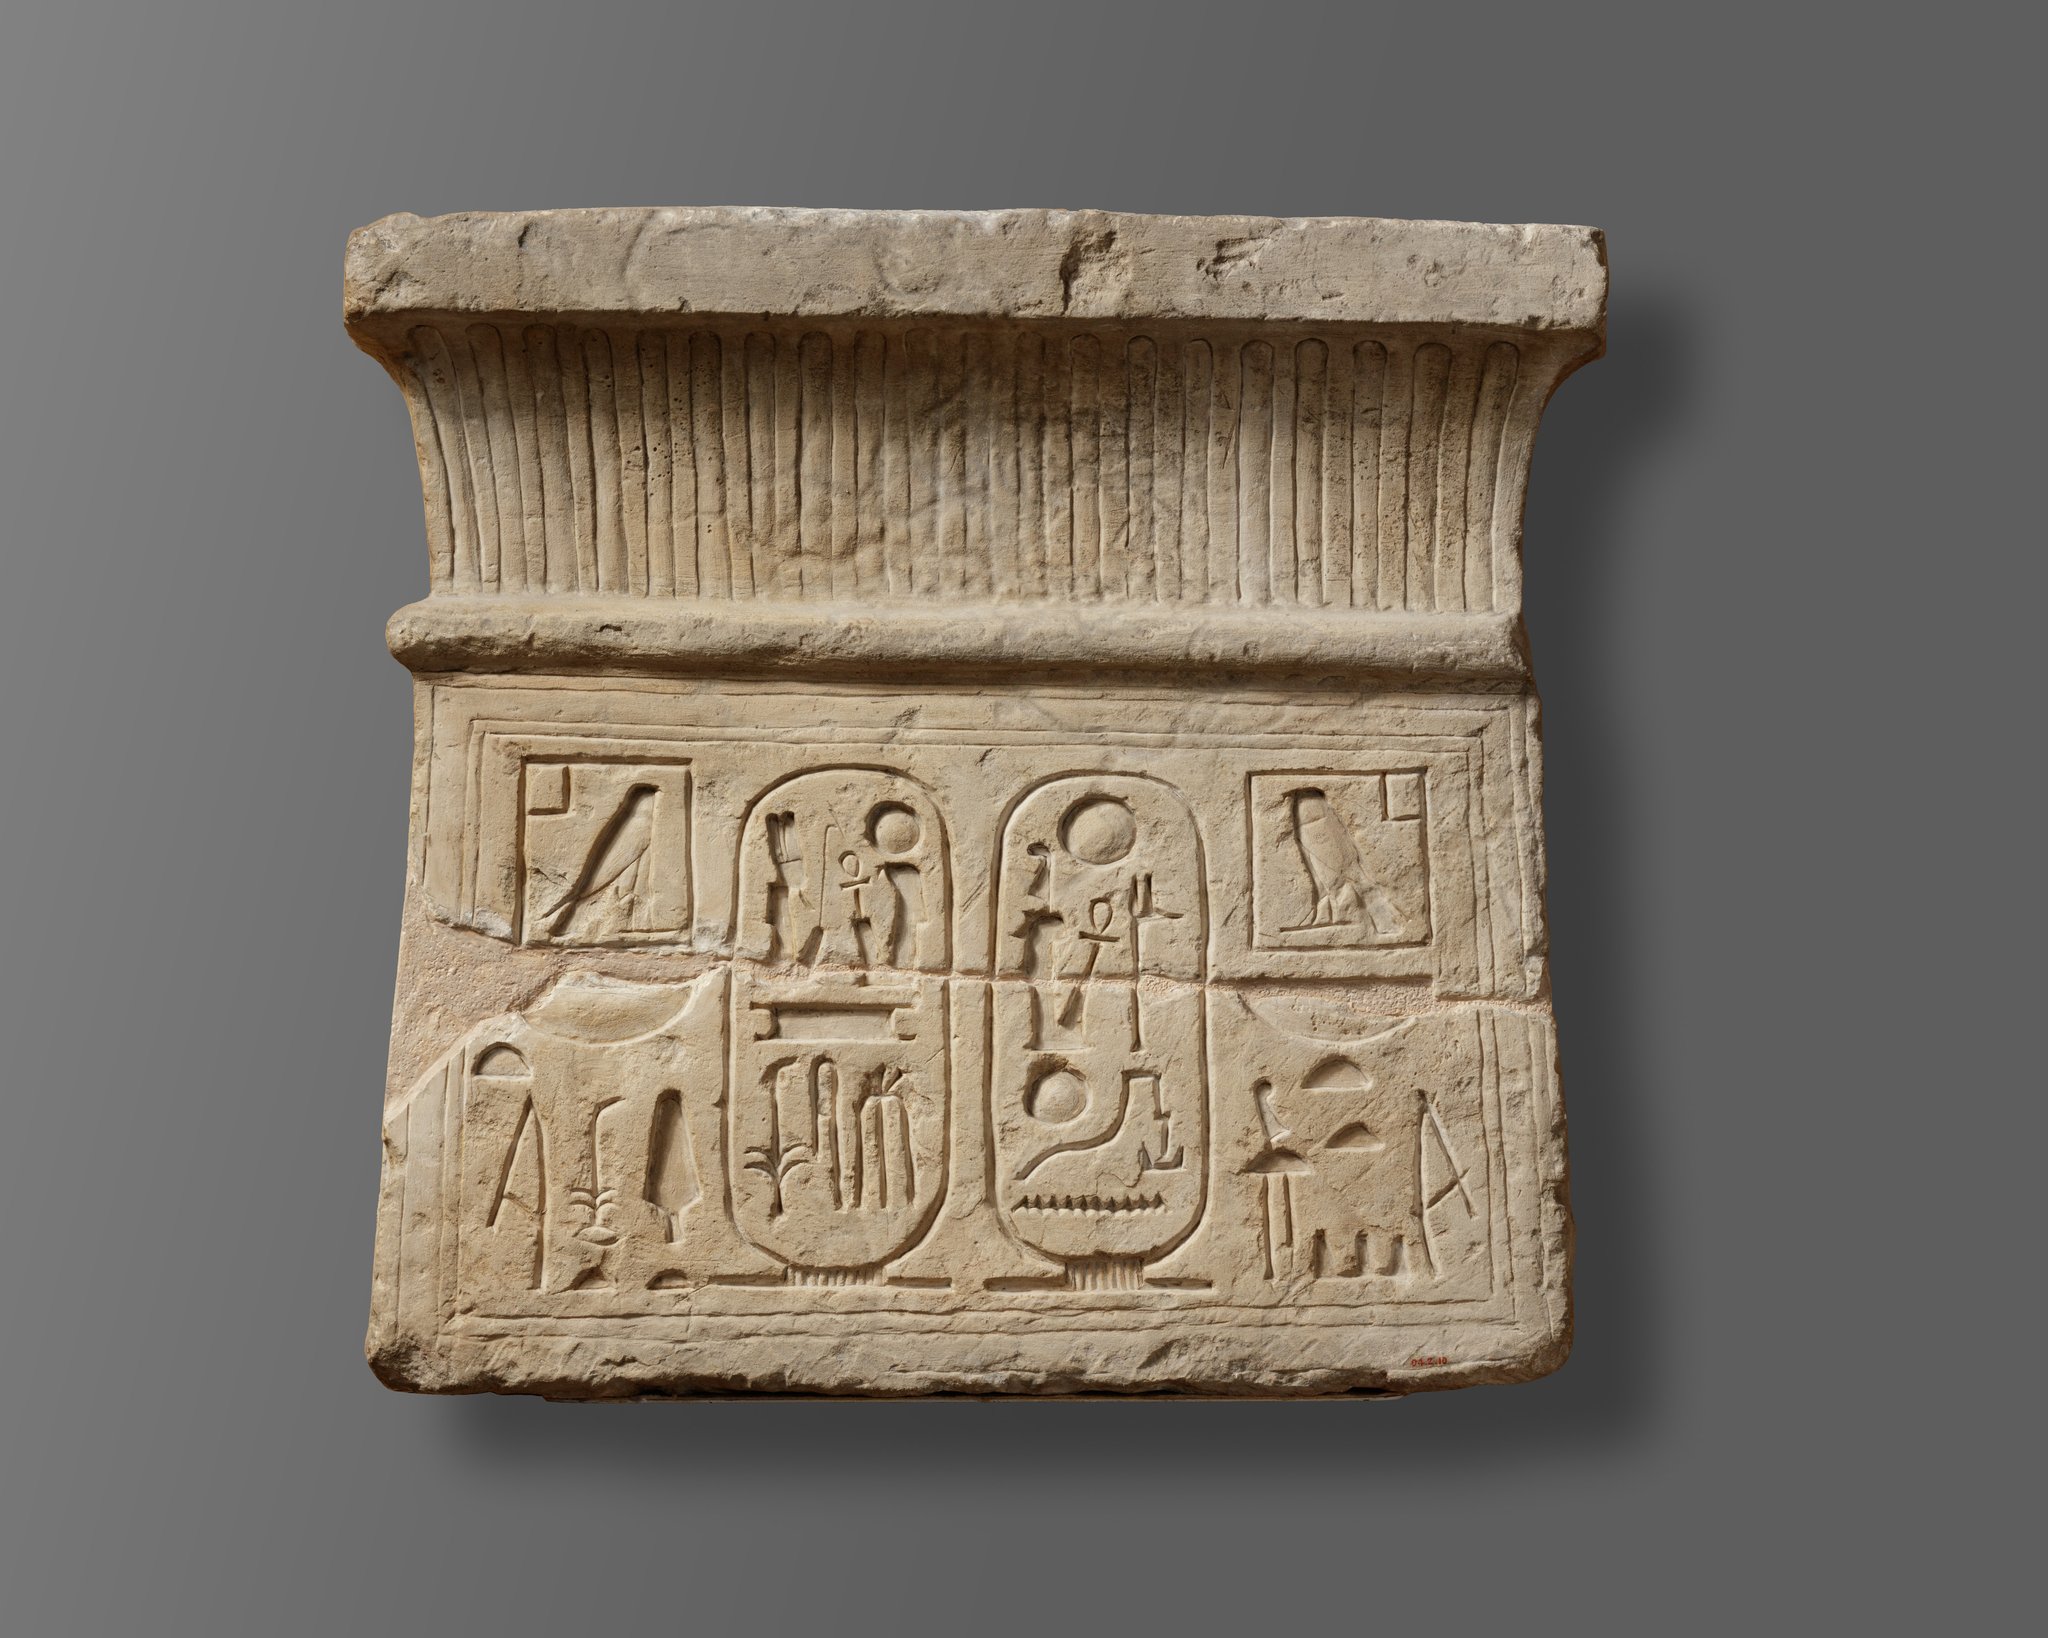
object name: stela, ramesses ii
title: Pylon shaped stela of Ramesses II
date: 1279-1213 BCE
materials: limestone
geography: egypt